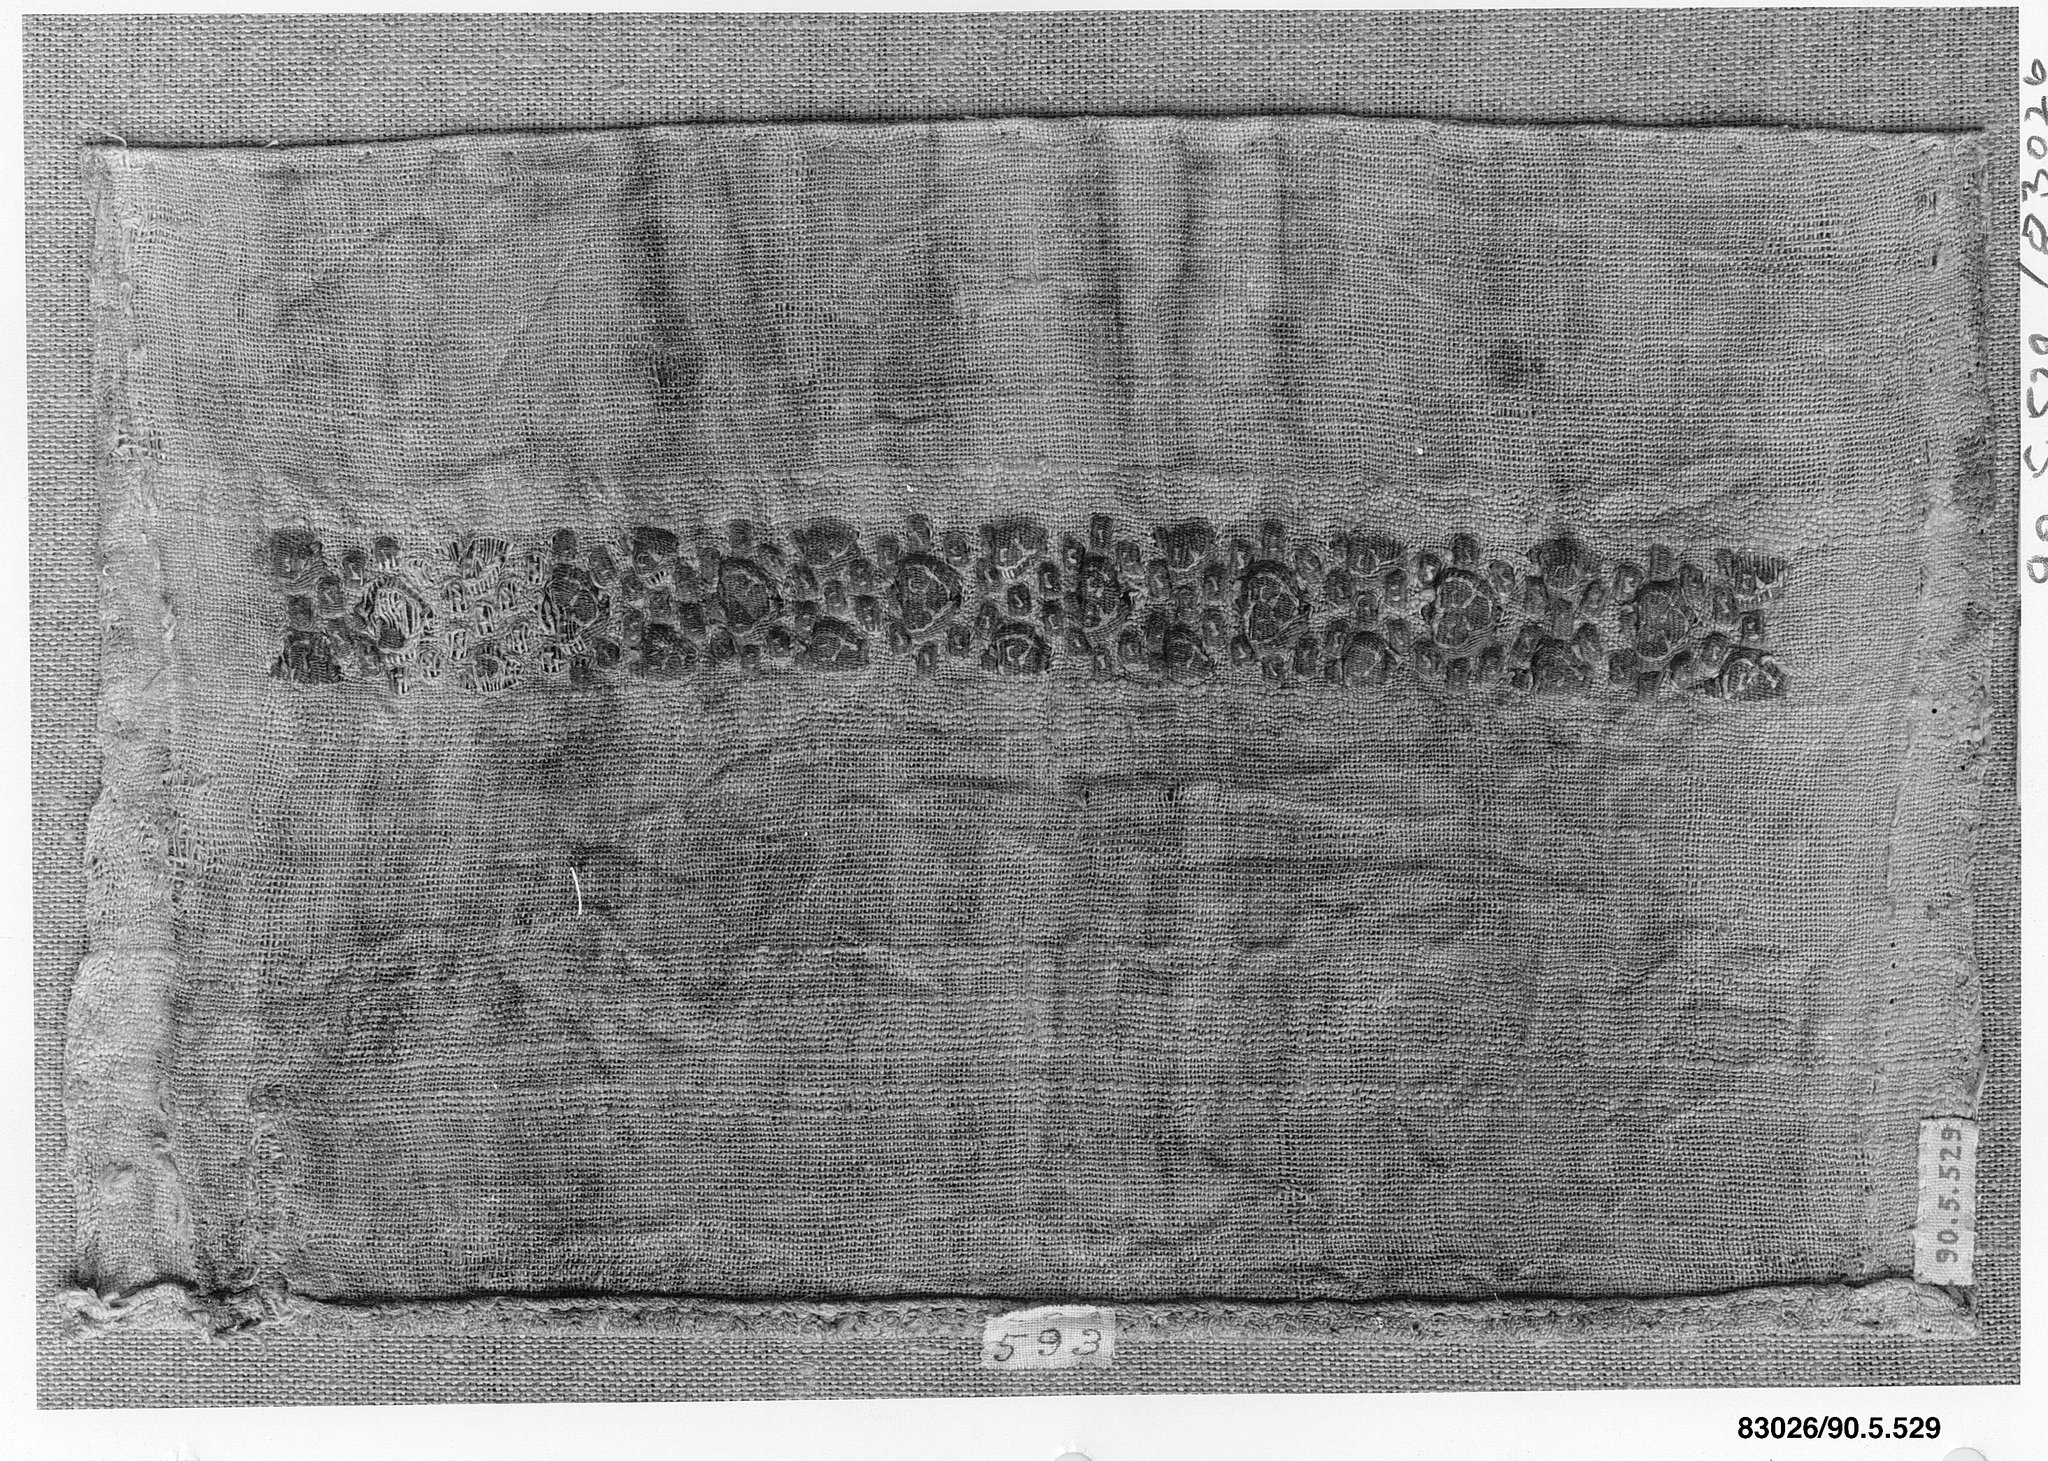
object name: textile fragment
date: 301-500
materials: linen, wool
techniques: weave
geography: egypt